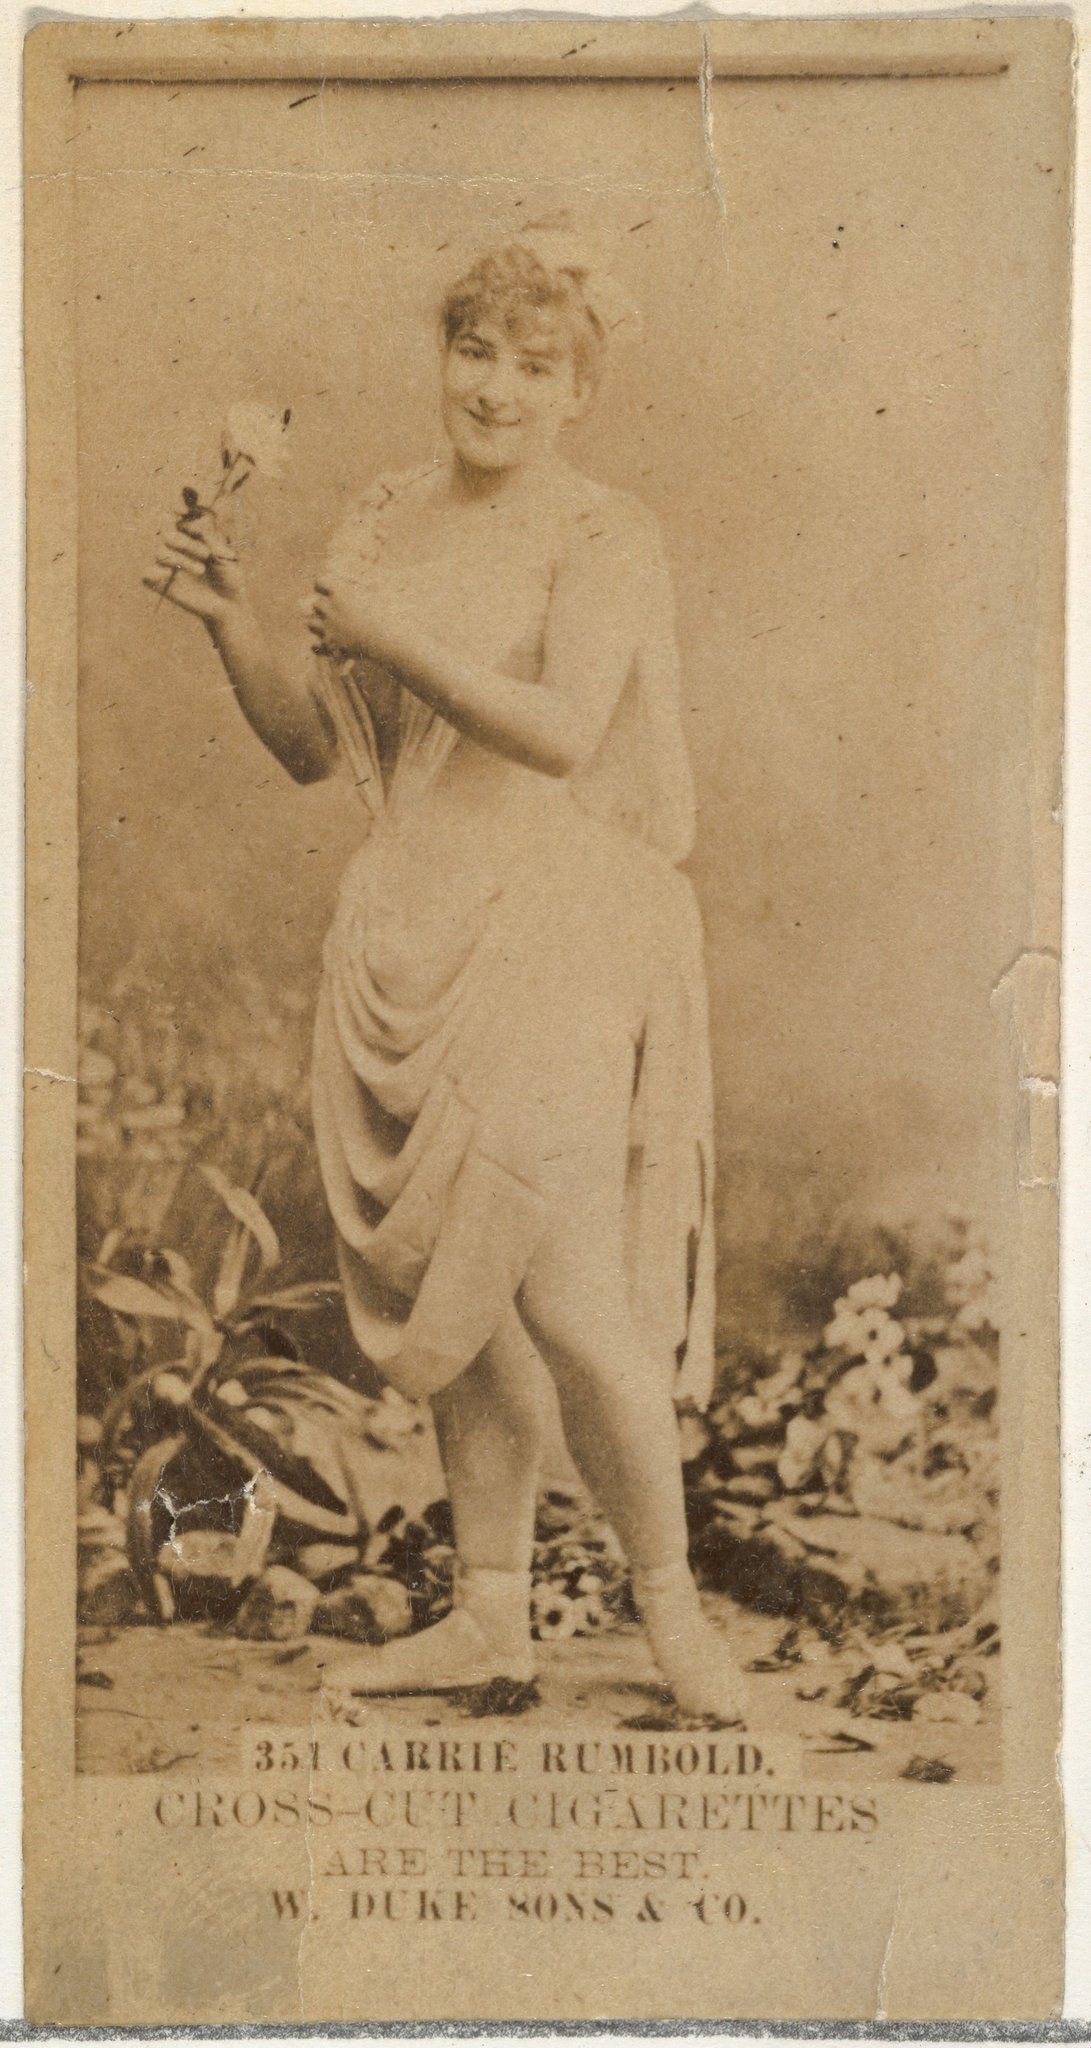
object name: photograph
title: Card Number 351, Carrie Rumbold, from the Actors and Actresses series (N145-3) issued by Duke Sons & Co. to promote Cross Cut Cigarettes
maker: w. duke, sons & co.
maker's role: publisher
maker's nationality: american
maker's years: 1870-1920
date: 1880-1889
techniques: albumen silver print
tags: portraits,women,actresses